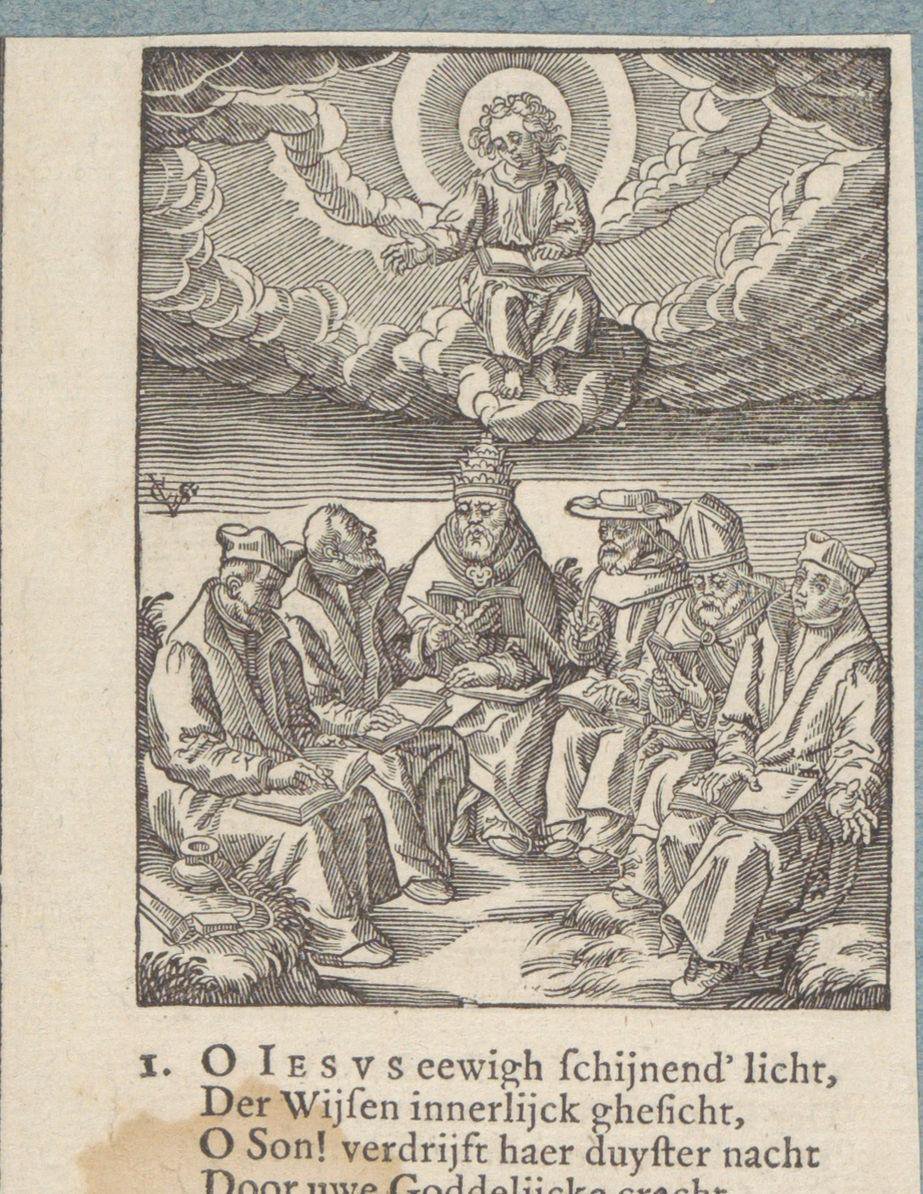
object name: print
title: Aanbidding van het Christuskind door geestelijken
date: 1629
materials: paper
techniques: letterpress printing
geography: amsterdam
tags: christ-child (with attributes), organization, functionaries and dignitaries in roman catholic church; clergy in general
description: Zes geestelijken aanbidden het Christuskind dat hen zegent vanaf een wolk. Het gezelschap bestaat uit een paus, een kardinaal, een bisschop en drie Jezuïeten. Onder de voorstelling genummerd 1 en vier regels tekst. De prent maakt deel uit van een album.